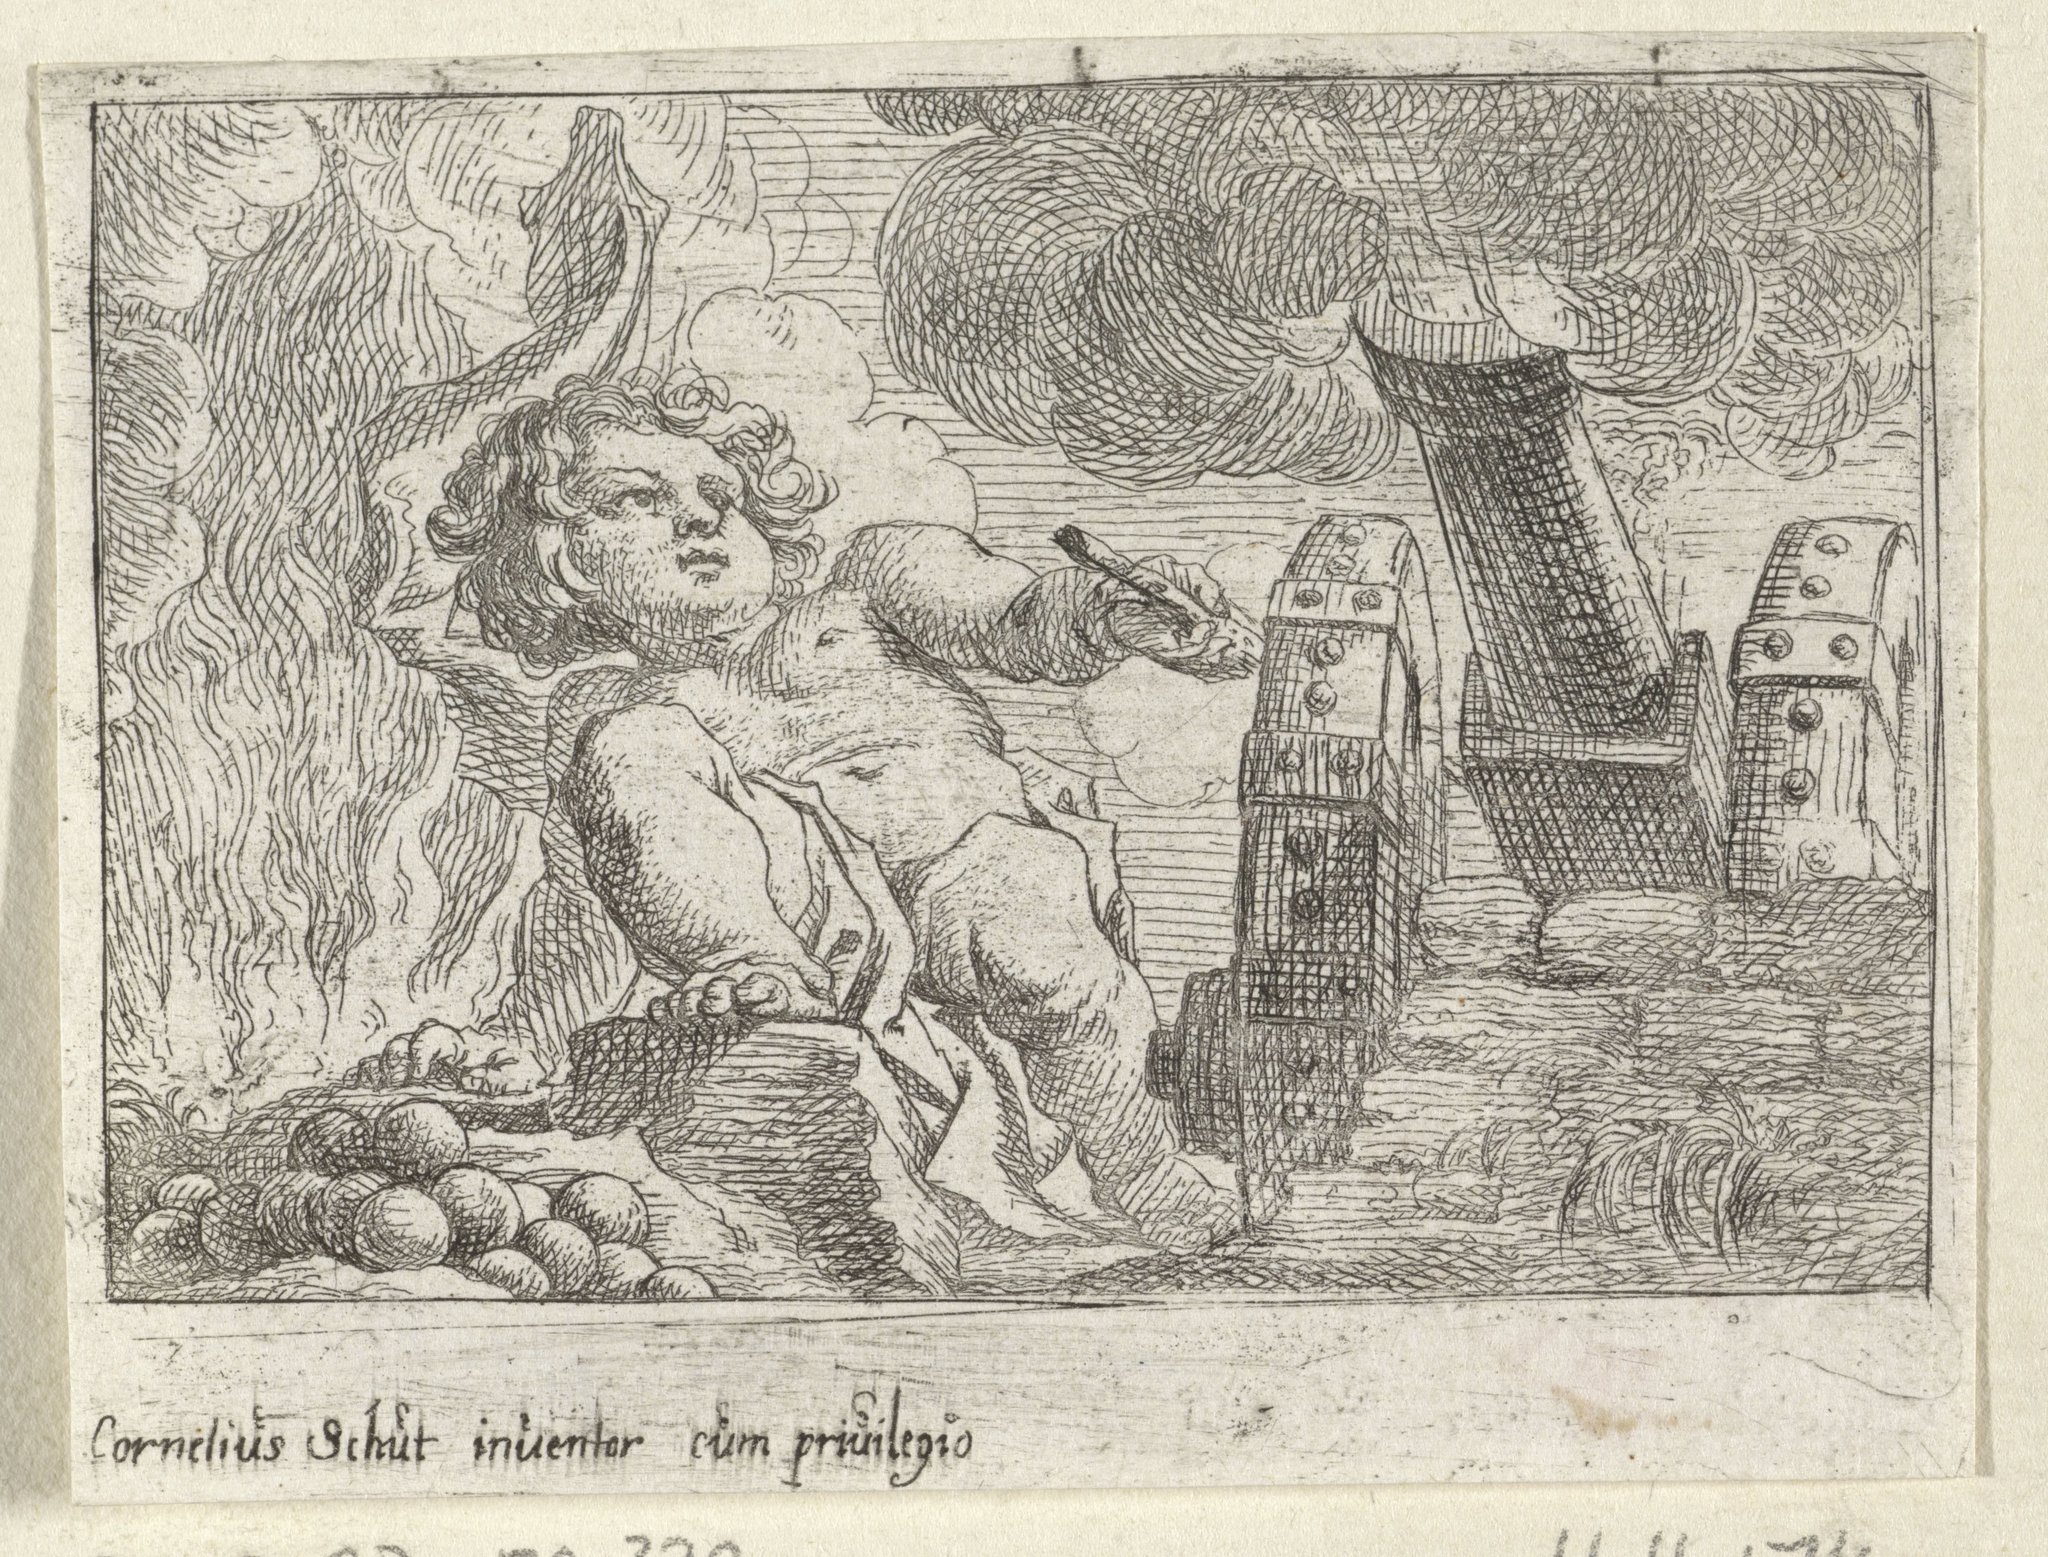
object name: print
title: Kind bij een kanon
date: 1618-1655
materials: paper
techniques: engraving, etching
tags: child, firearms: cannon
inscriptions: collector's mark: Lugt 240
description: Een kind vuurt een kanon af. Het heeft een lont in de hand. Op de voorgrond een stapel kogels.